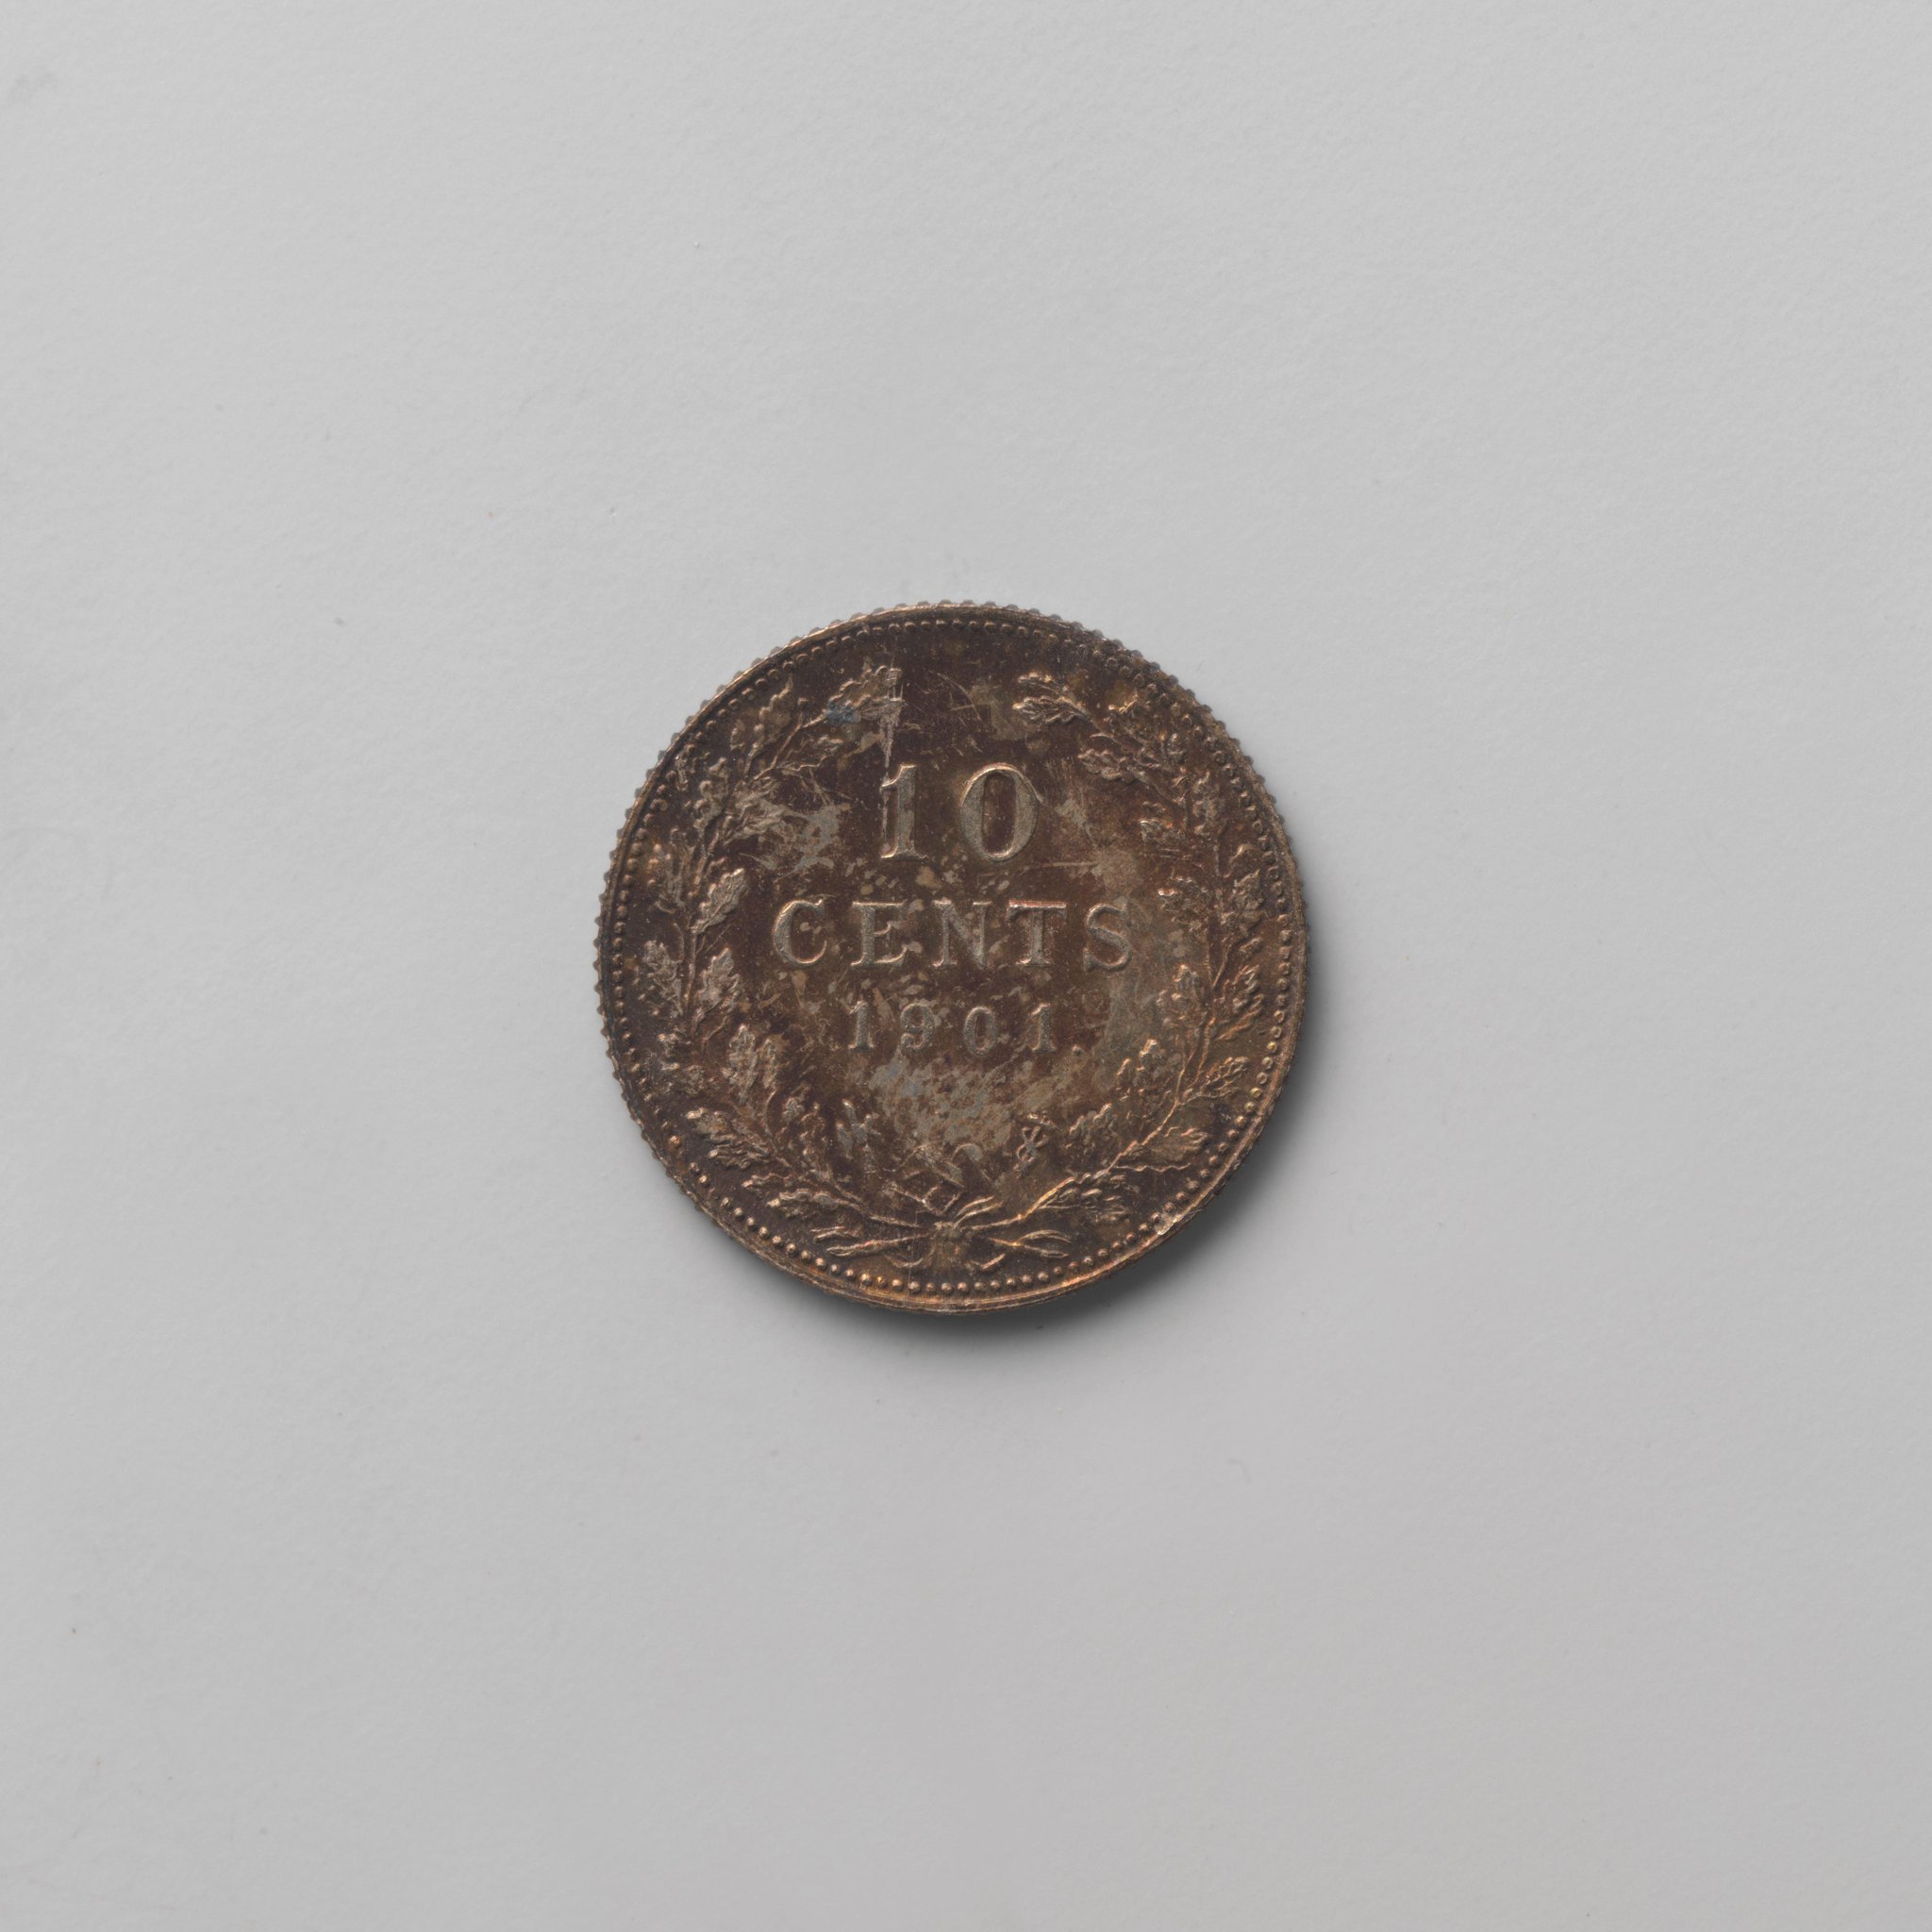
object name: coin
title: Nederland,10 cent,1901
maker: wilhelmina of the netherlands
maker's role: print maker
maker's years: 1880-1962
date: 1901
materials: silver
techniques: striking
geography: utrecht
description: Zilveren munt. Voorzijde: hoofd met diadeem naar links. Keerzijde: binnen twee samengebonden eiketakken waarde-aanduiding 10 cents en jaartal. Kartelrand.